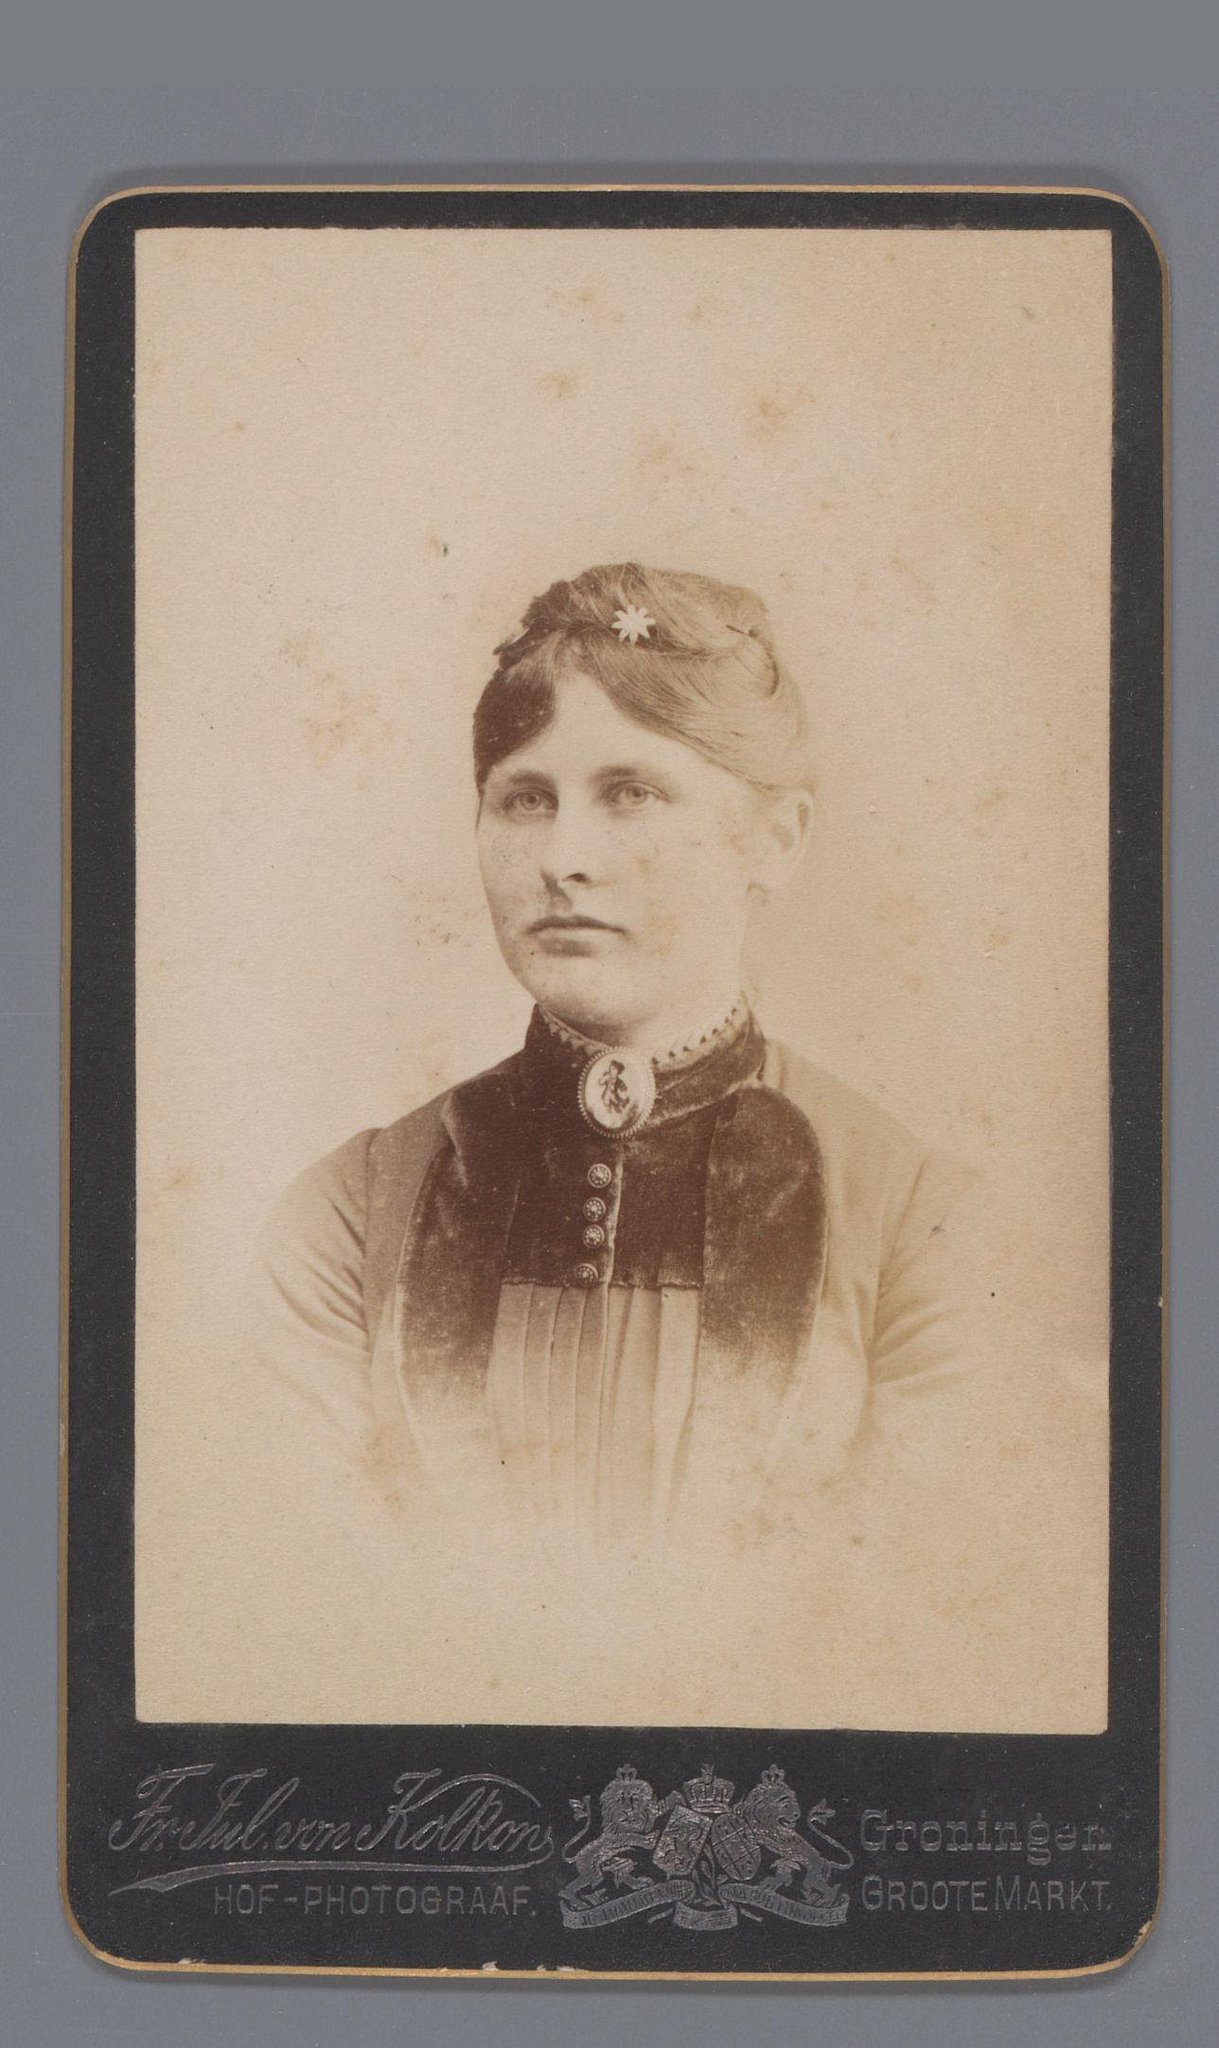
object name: photograph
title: Portret van een onbekende vrouw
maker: friedrich julius von kolkow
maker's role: fotograaf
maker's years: 1839-1914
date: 1884-1896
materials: cardboard, paper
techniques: albumen print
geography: groningen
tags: historical persons - bb - woman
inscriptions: inscription: ‘GOUDEN MEDALJE VOOR KUNST EN WETENSCHAP v Z. M. de KONING v WÜRTTEMBERG/ aan het lint der Frederiksorde/ PHILADELPHIA 1876. WIEN 1873./ FR. JUL. VON KOLKOW/ KONINKLIJK NEDERLANDSCH HOF-PHOTOGRAPH/ Silberne Voigtländer Medaille Kunst u Wissenschaft Oldenburg/ en tien zilveren Medaljes op andere Tentoonstellingen./ GRONINGEN/ Groote Markt bij de/ Martinitoorn./ Specialiteit in Vergrootingen.’